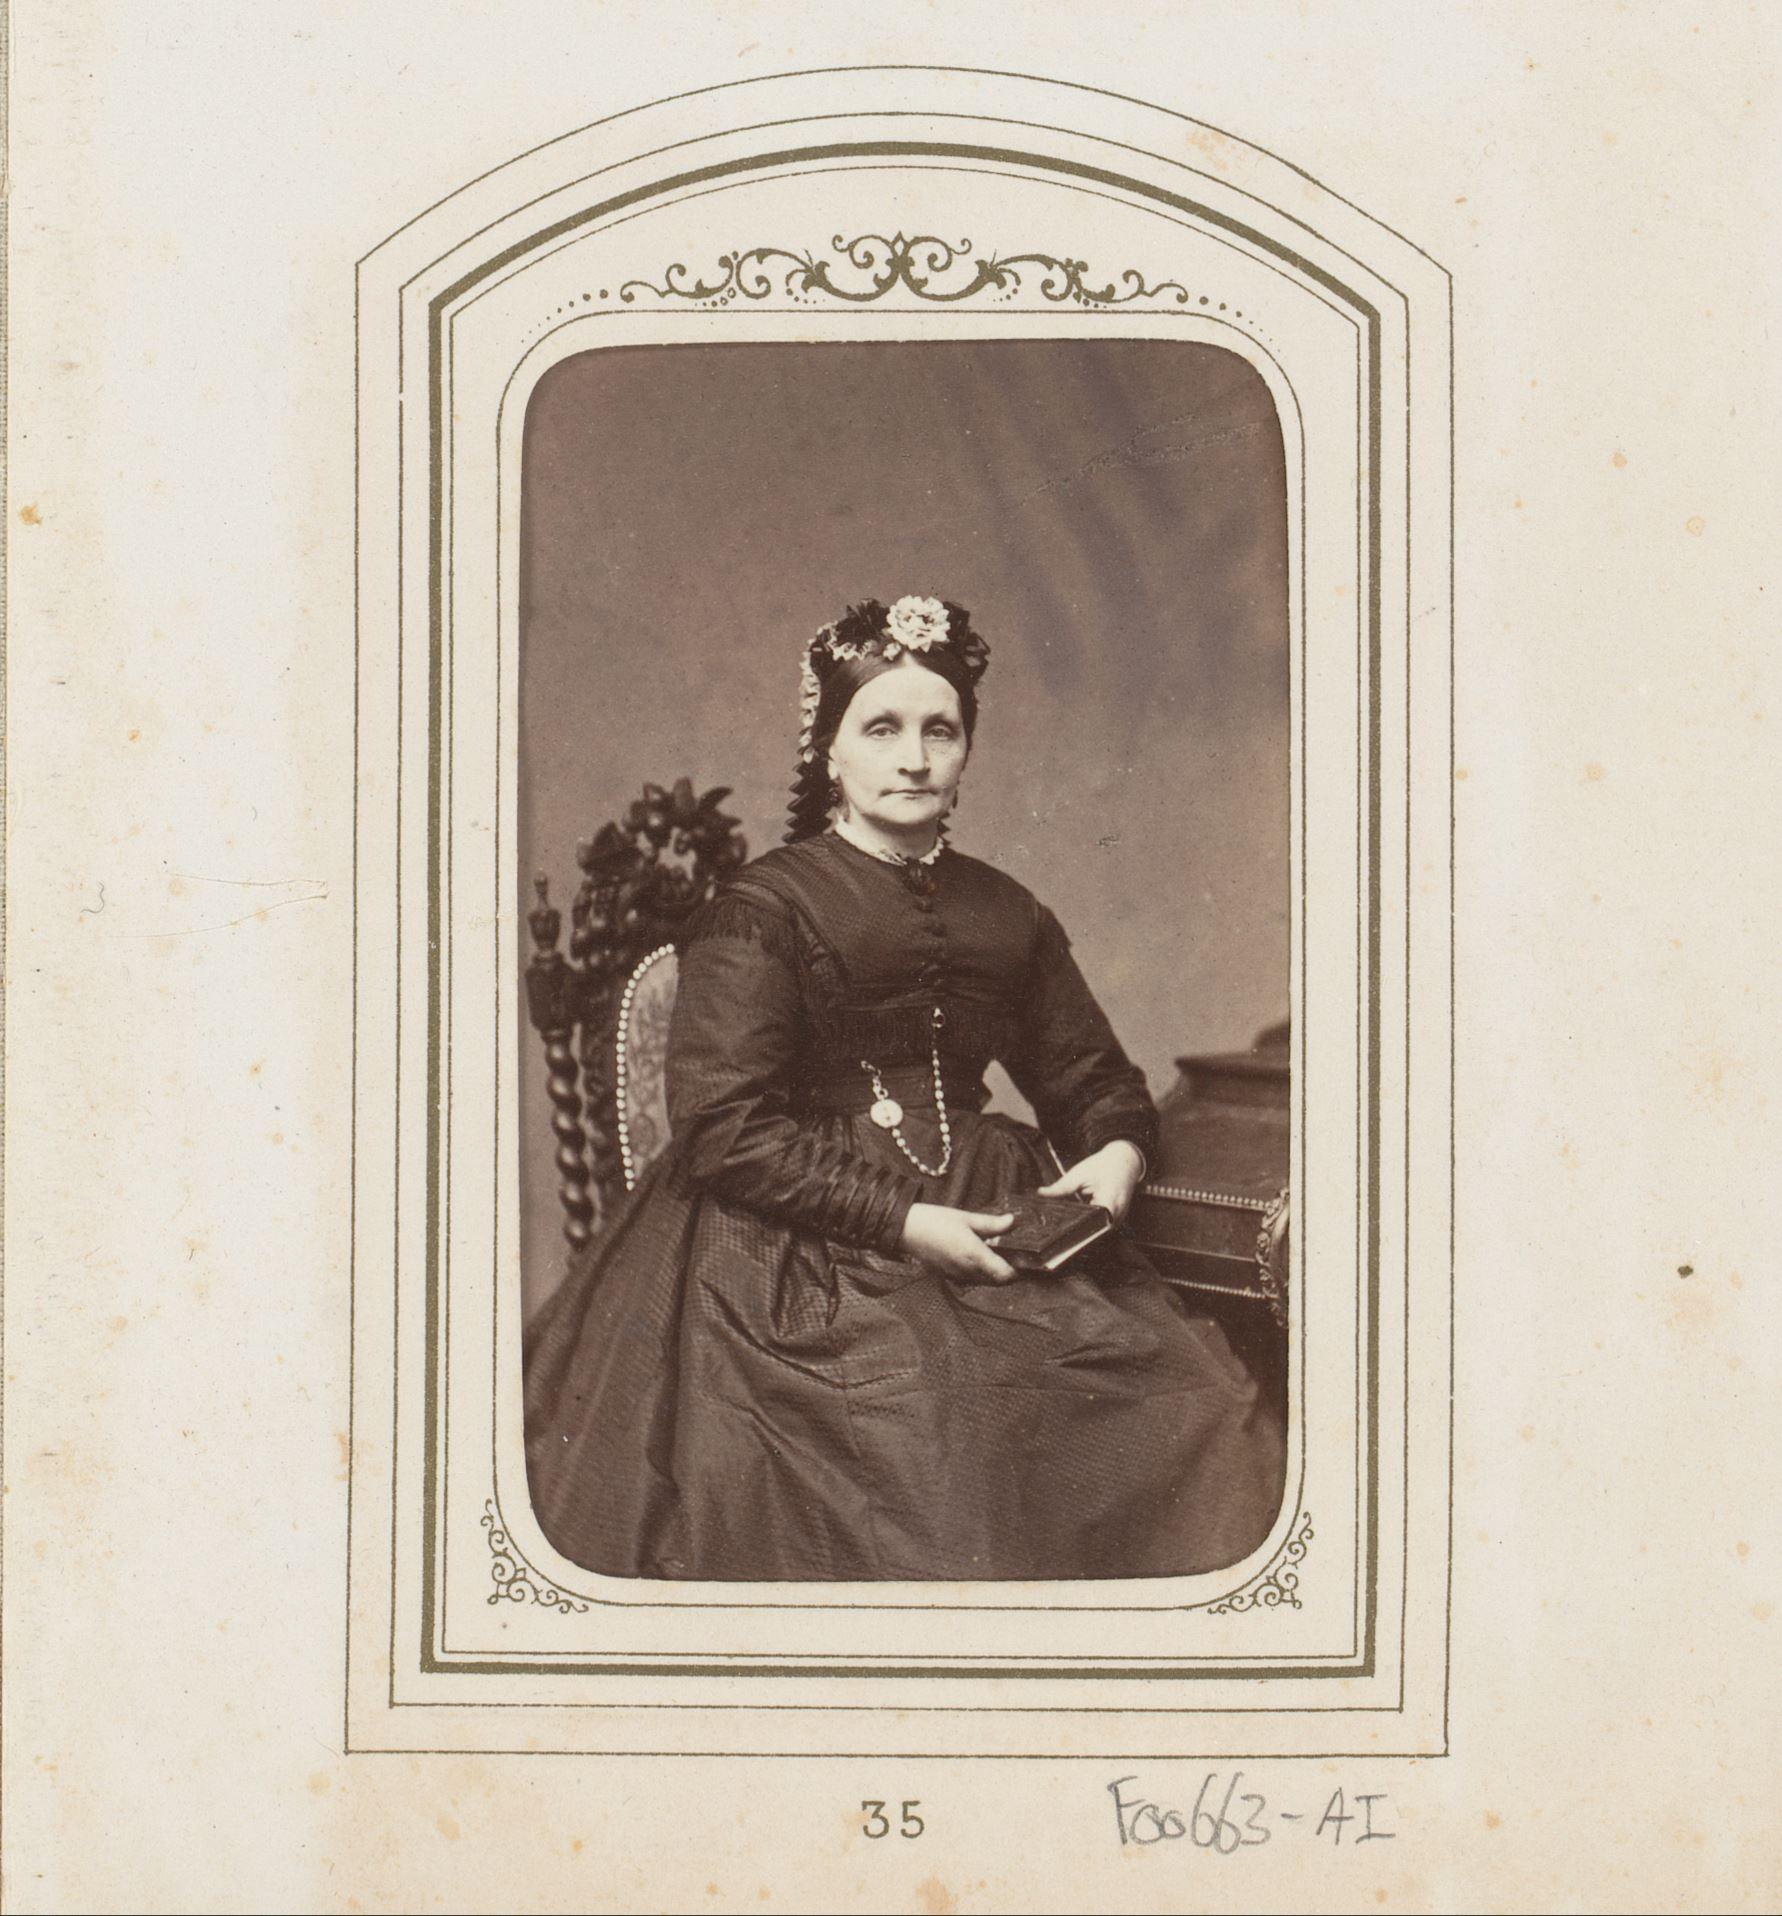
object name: photograph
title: Portret van een zittende vrouw met boek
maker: eduard fuchs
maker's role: painter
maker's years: 1832-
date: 1859-1870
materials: cardboard, photographic support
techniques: albumen print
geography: leeuwarden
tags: historical persons - bb - woman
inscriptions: inscription: ‘Photographie/ E. Fuchs/ Leeuwarden’, number: ‘35’